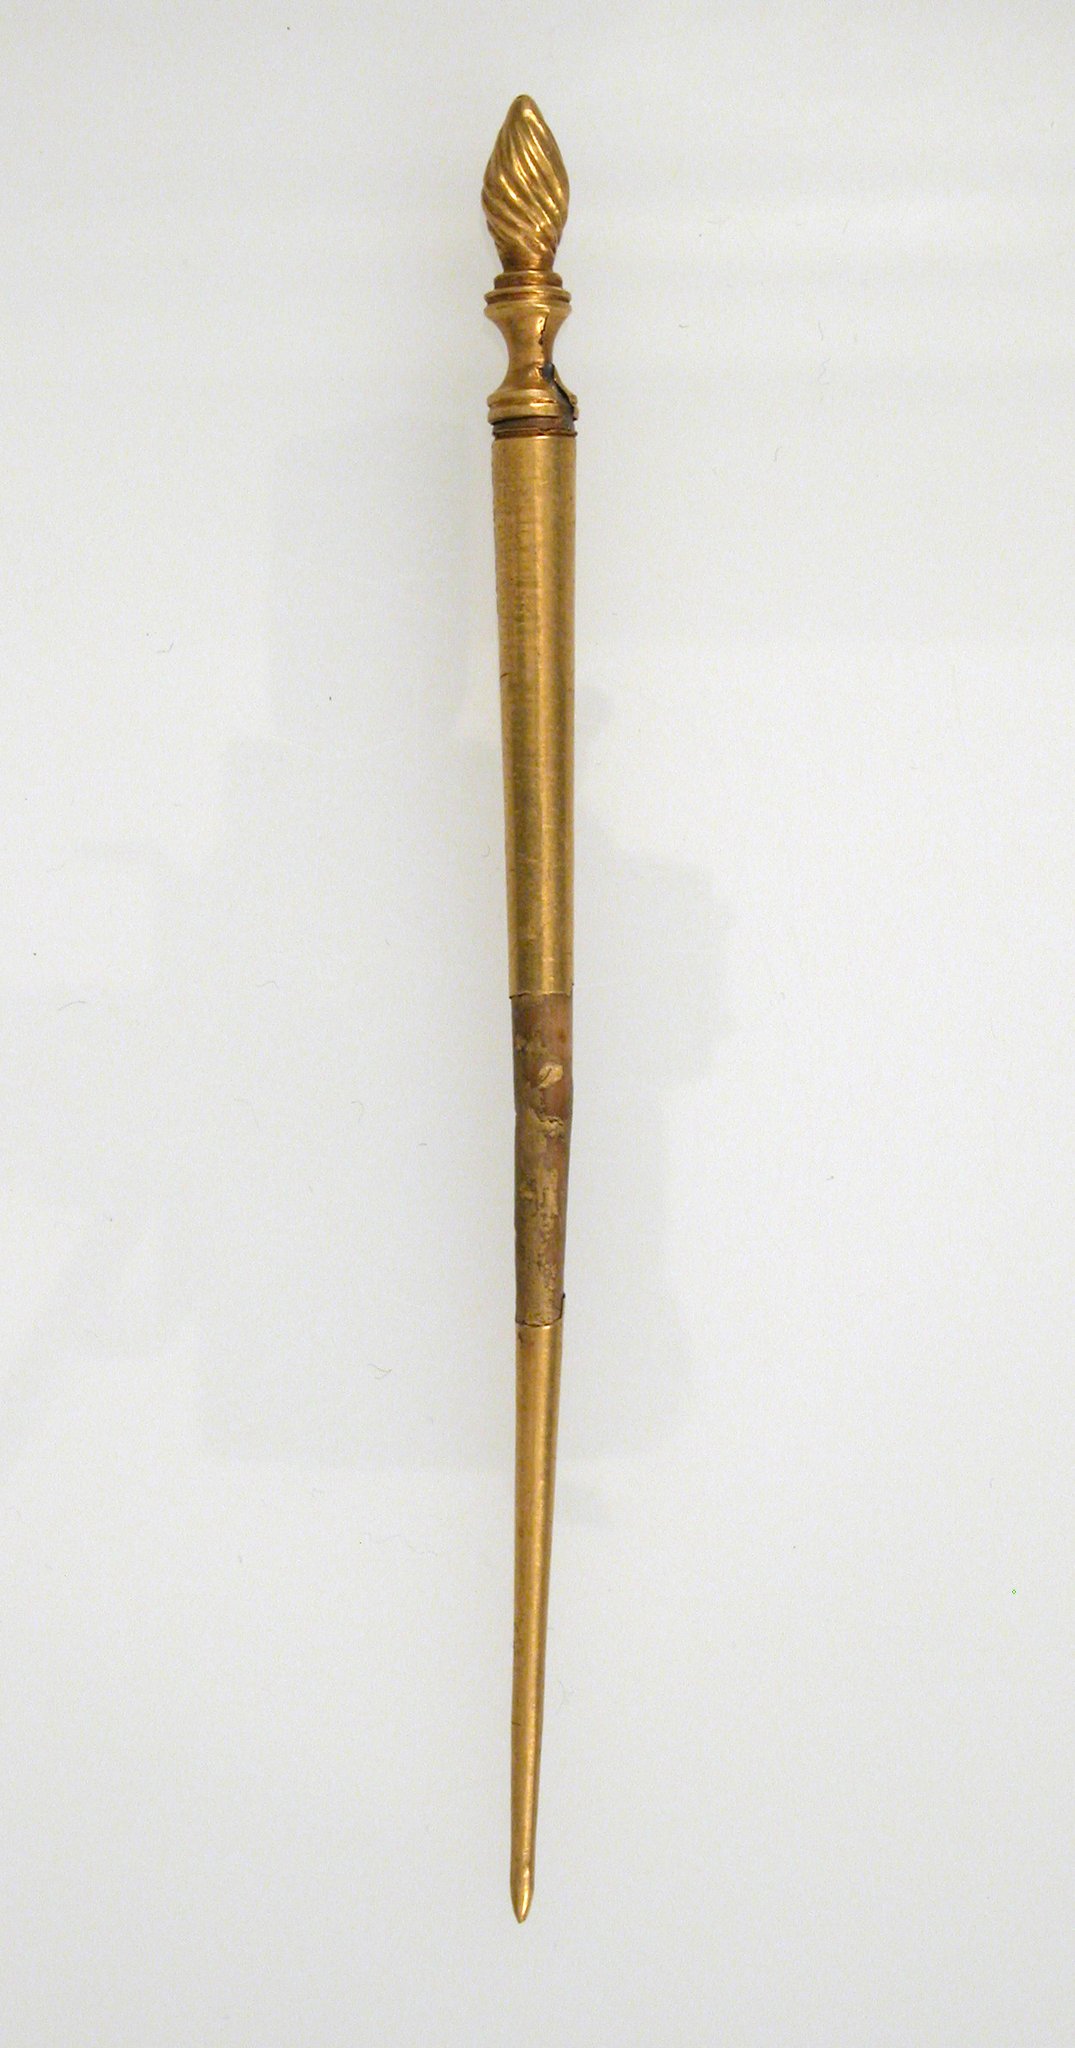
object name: hairpin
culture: frankish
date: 601-700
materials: gold, wood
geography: northern france